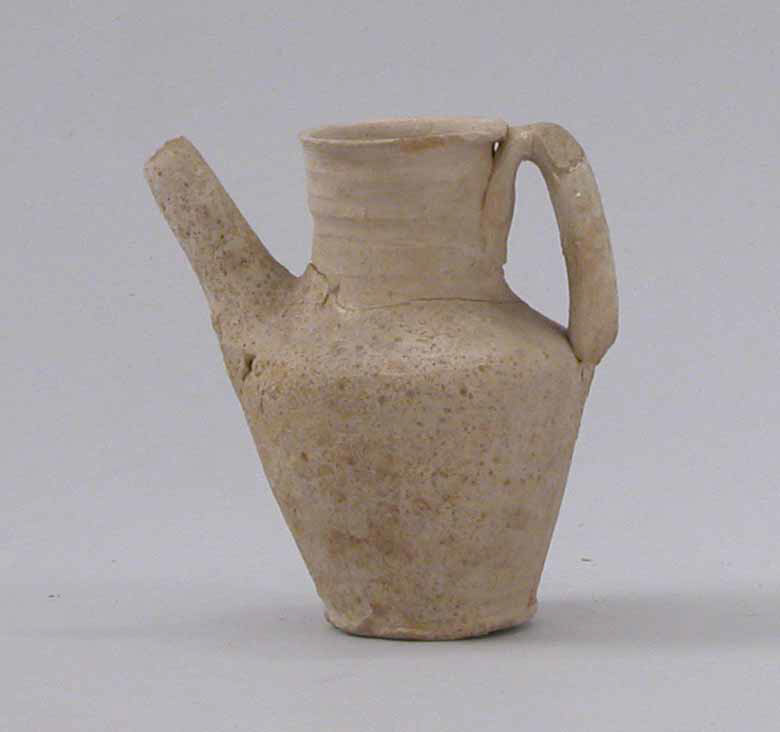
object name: jug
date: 801-1000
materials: earthenware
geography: iran